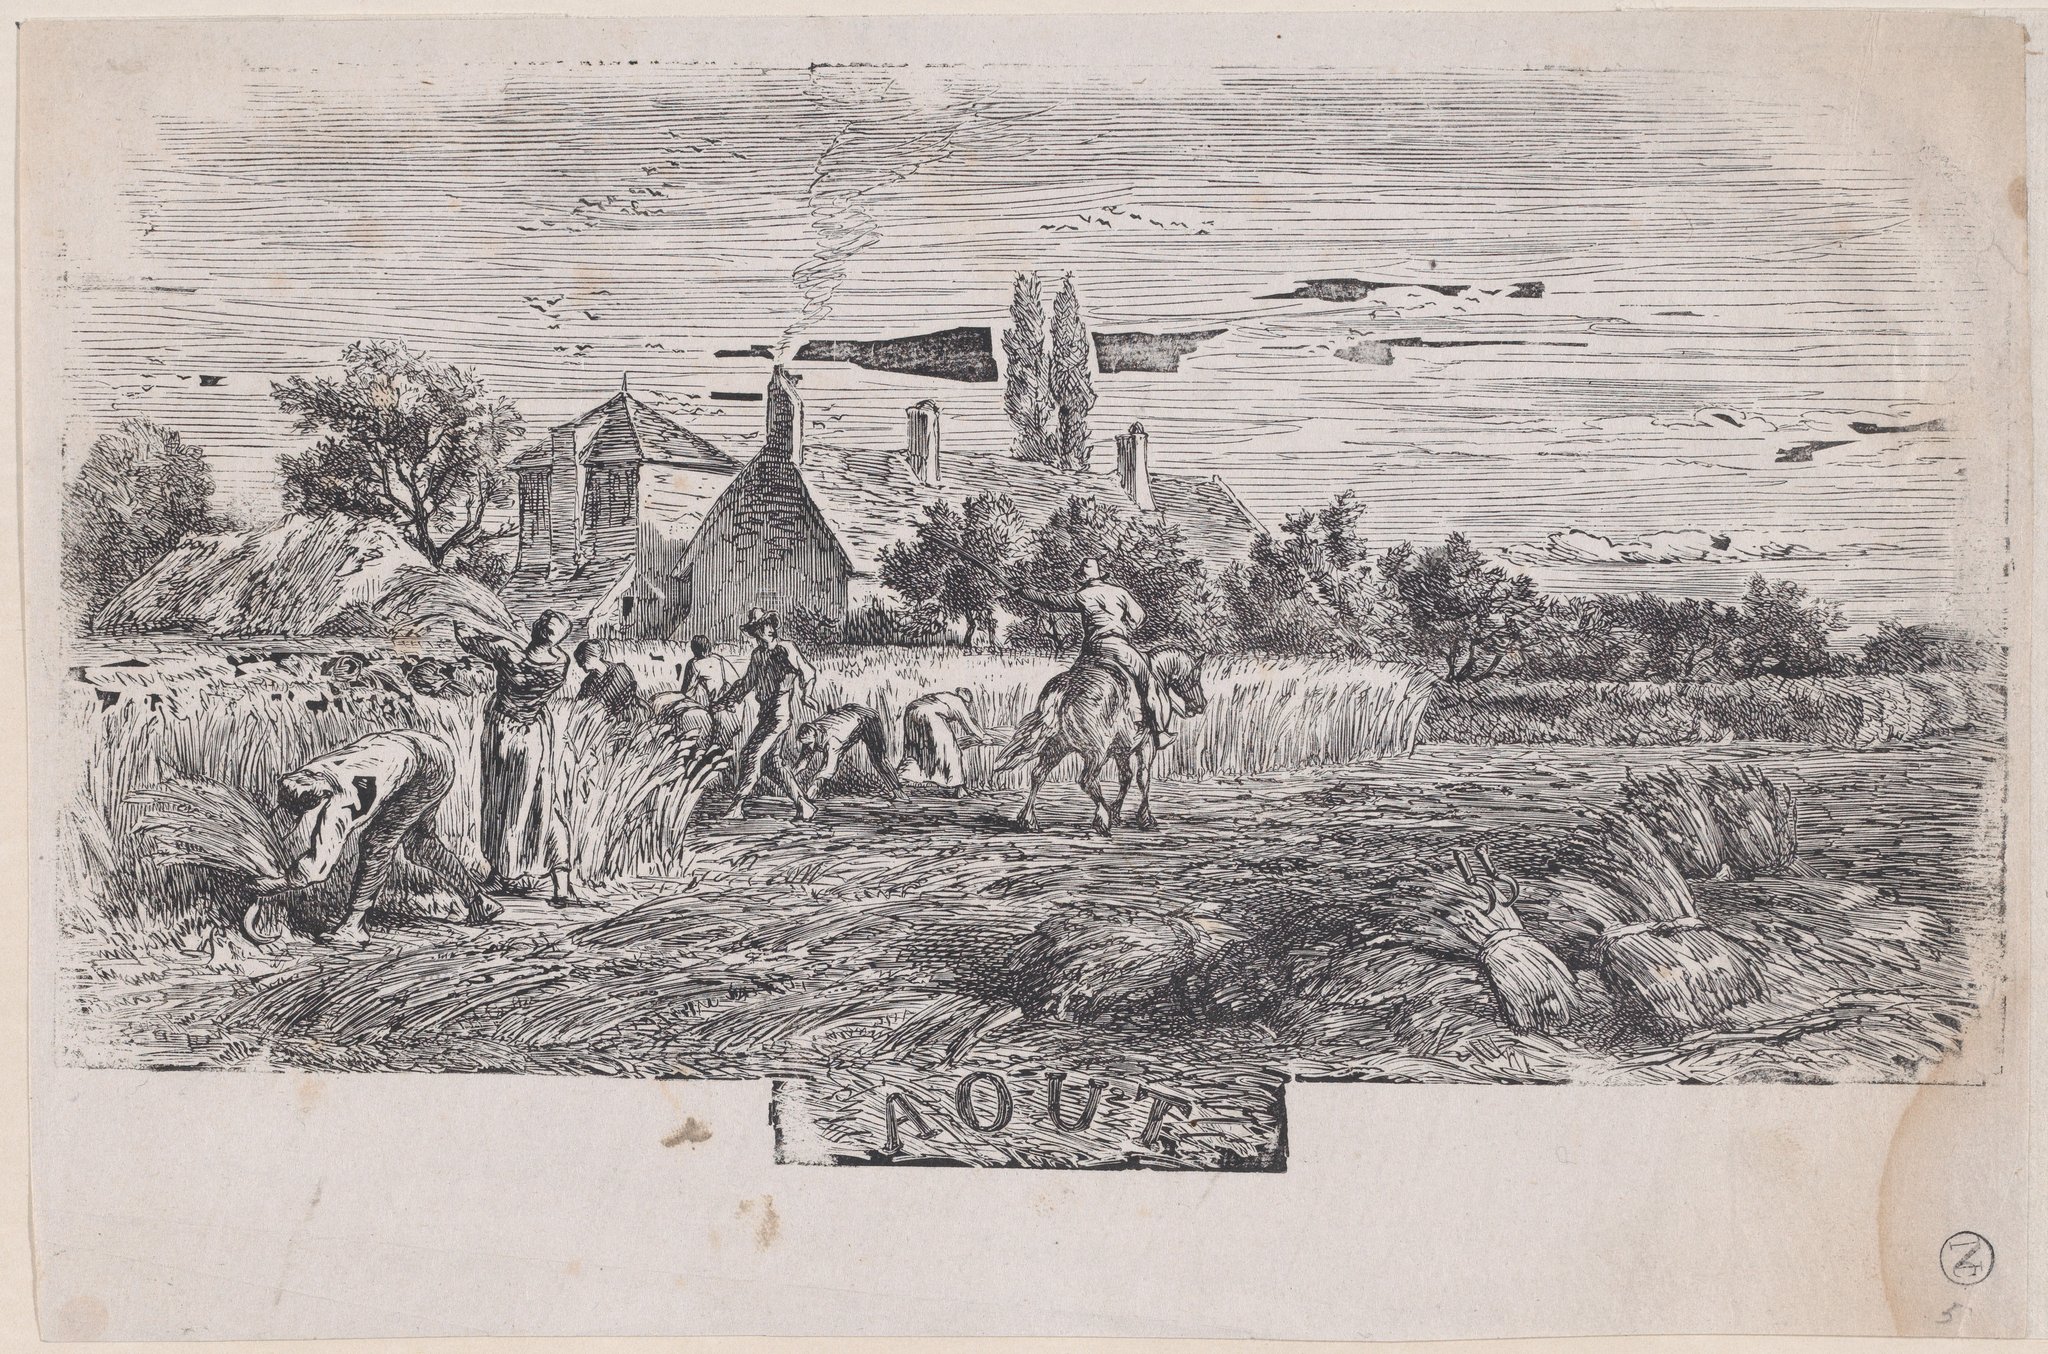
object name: print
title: August, from "Album of Rustic Subjects"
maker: charles émile jacque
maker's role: artist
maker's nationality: french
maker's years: 1813-1894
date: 1859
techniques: engraving